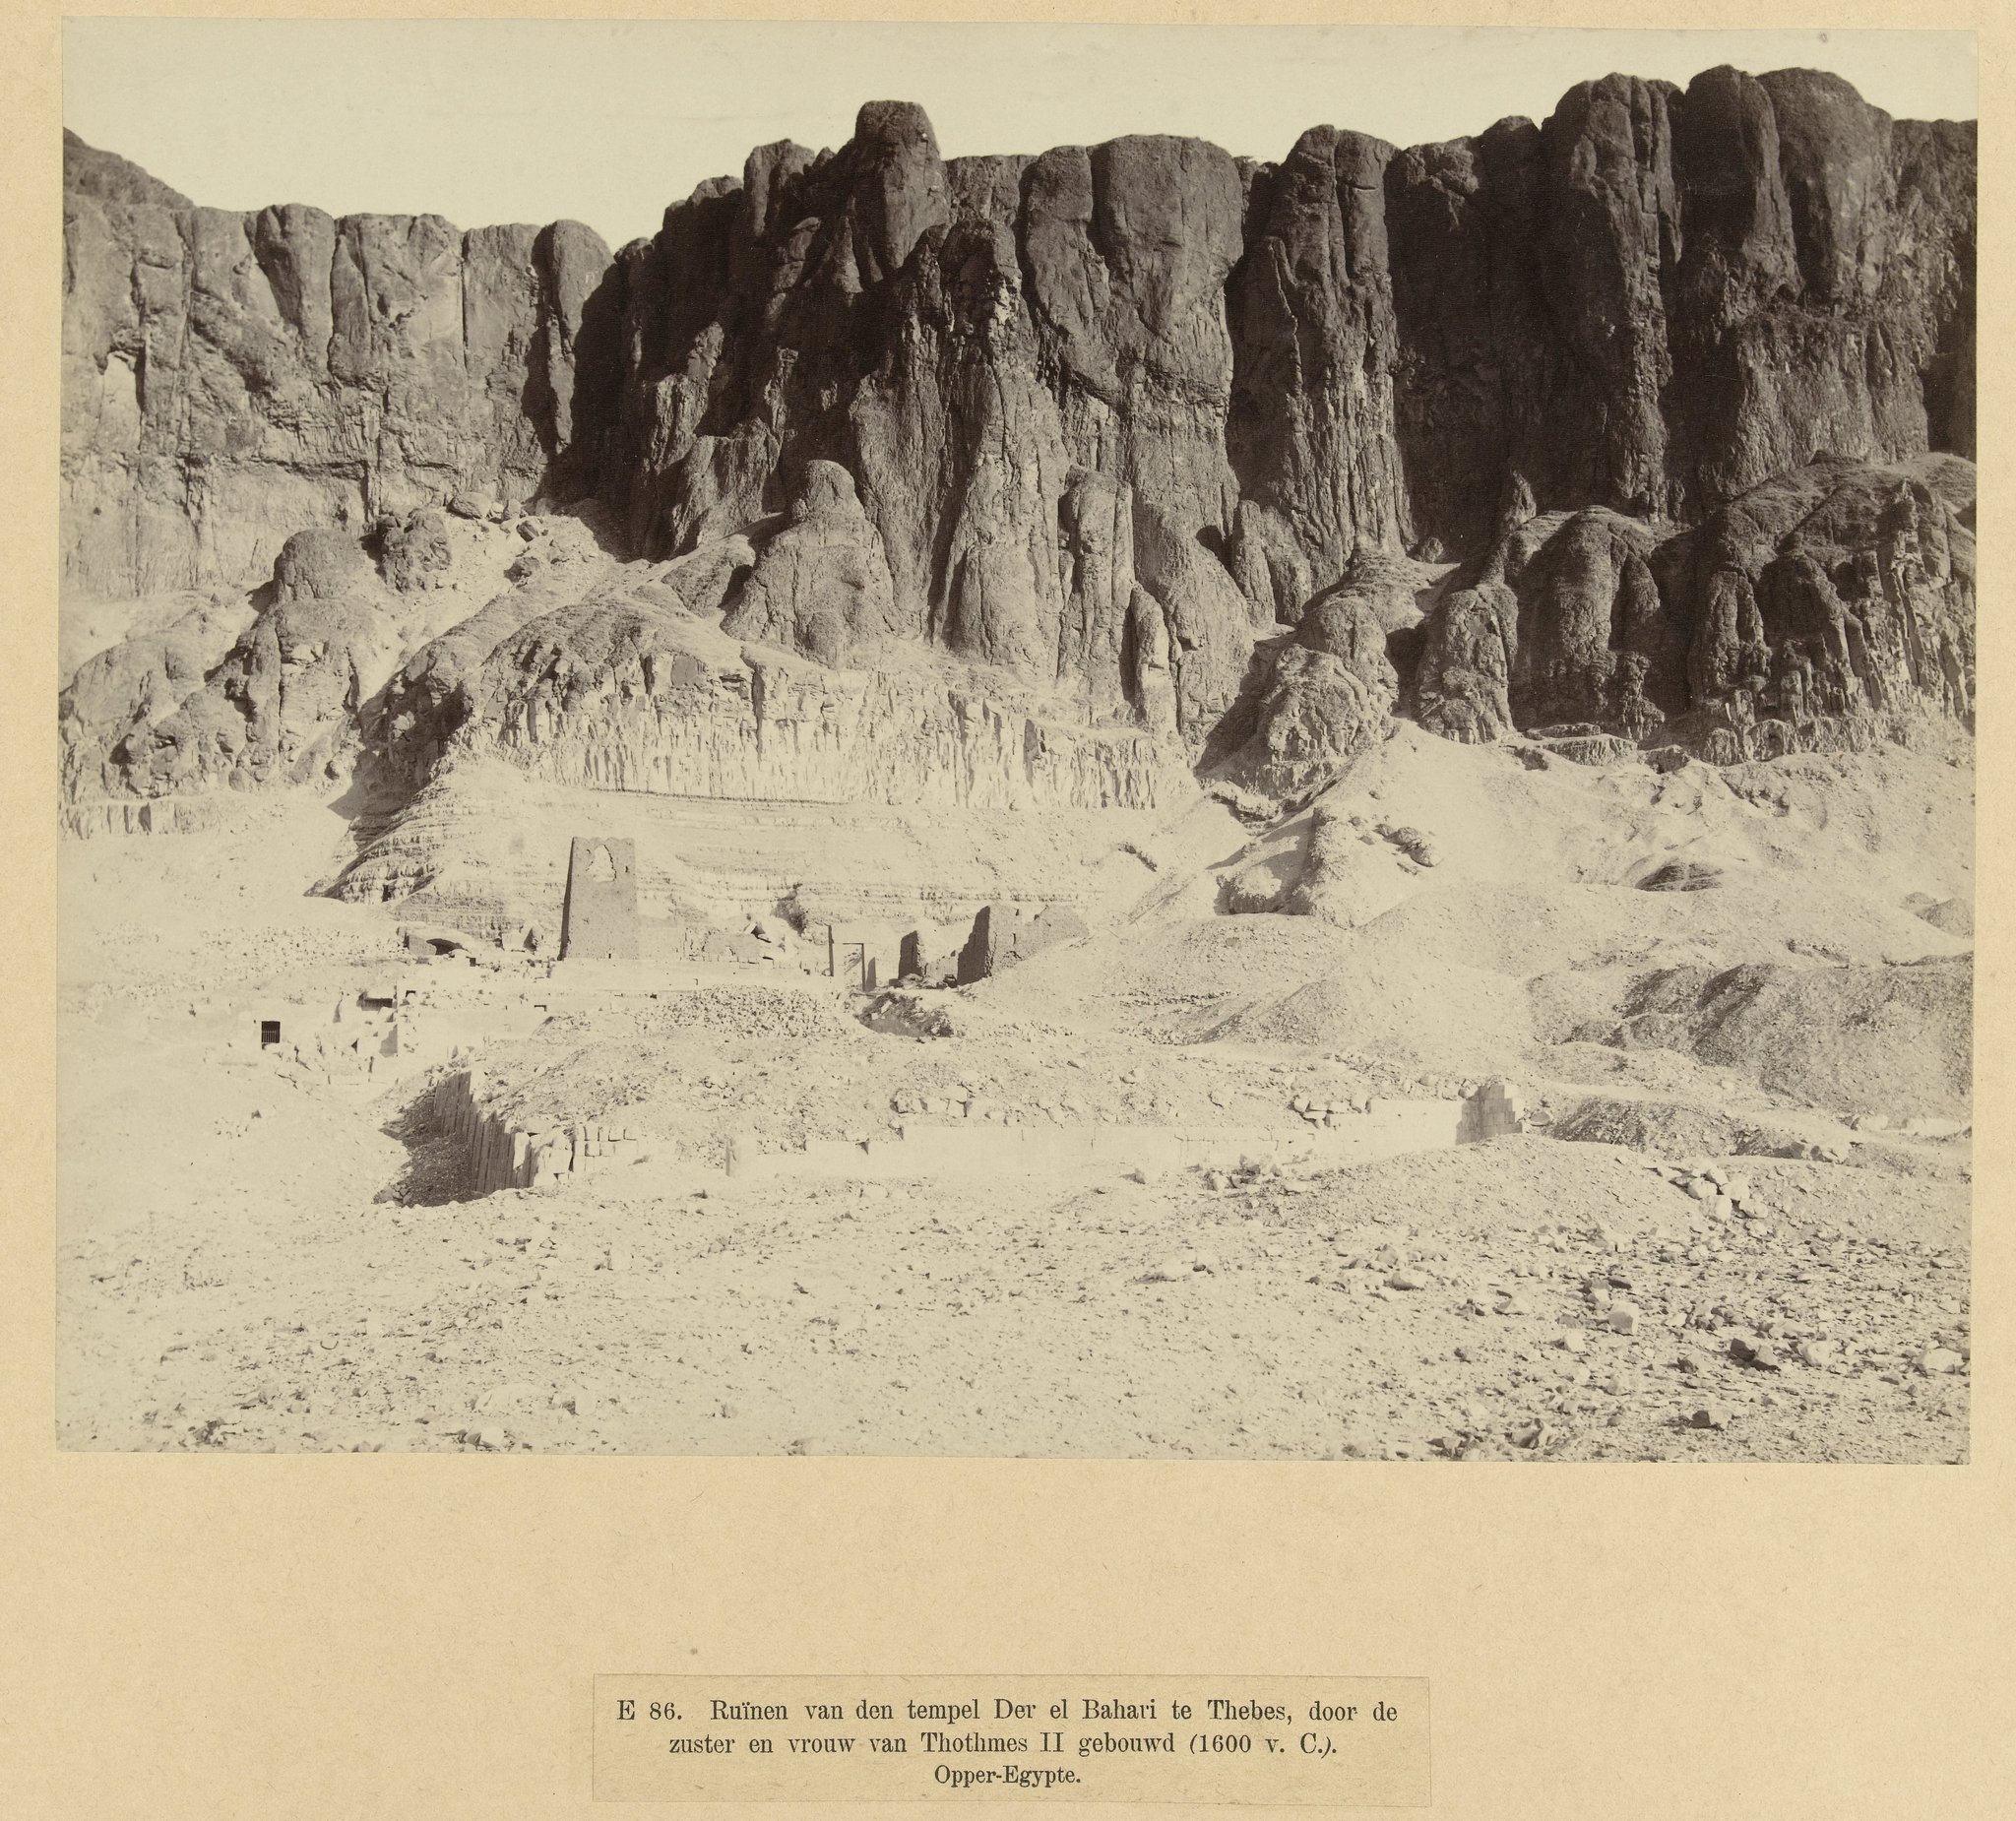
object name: photograph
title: Gezicht op Deir el-Bahri op de westoever van de Nijl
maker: Anonymous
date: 1890-1895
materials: cardboard, paper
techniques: albumen print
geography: thebes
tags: dale, valley, landscape with ruins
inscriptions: stamp: ‘GEMEENTELIJKE BIBLIOTHEEK/ ROTTERDAM’, title: ‘E 86. Ruïnen van den tempel Der el Bahari te Tebes, door de zuster em vrouw van Thothmes II gebouwd (1600 v. C.). Opper Egypte.’, check stamp: ‘Bristol/ L.M’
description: Onderdeel van een groep door fotograaf Richard Polak op reis verzamelde foto’s. Deze foto is samen met andere op zijn reizen verzamelde foto's tentoongesteld bij de Rotterdamsche Kunstkring (1895), Arti en Amicitiae te Amsterdam (1897-1898?) en Societeit 't Collegie te Kampen (datum vooralsnog onbekend).